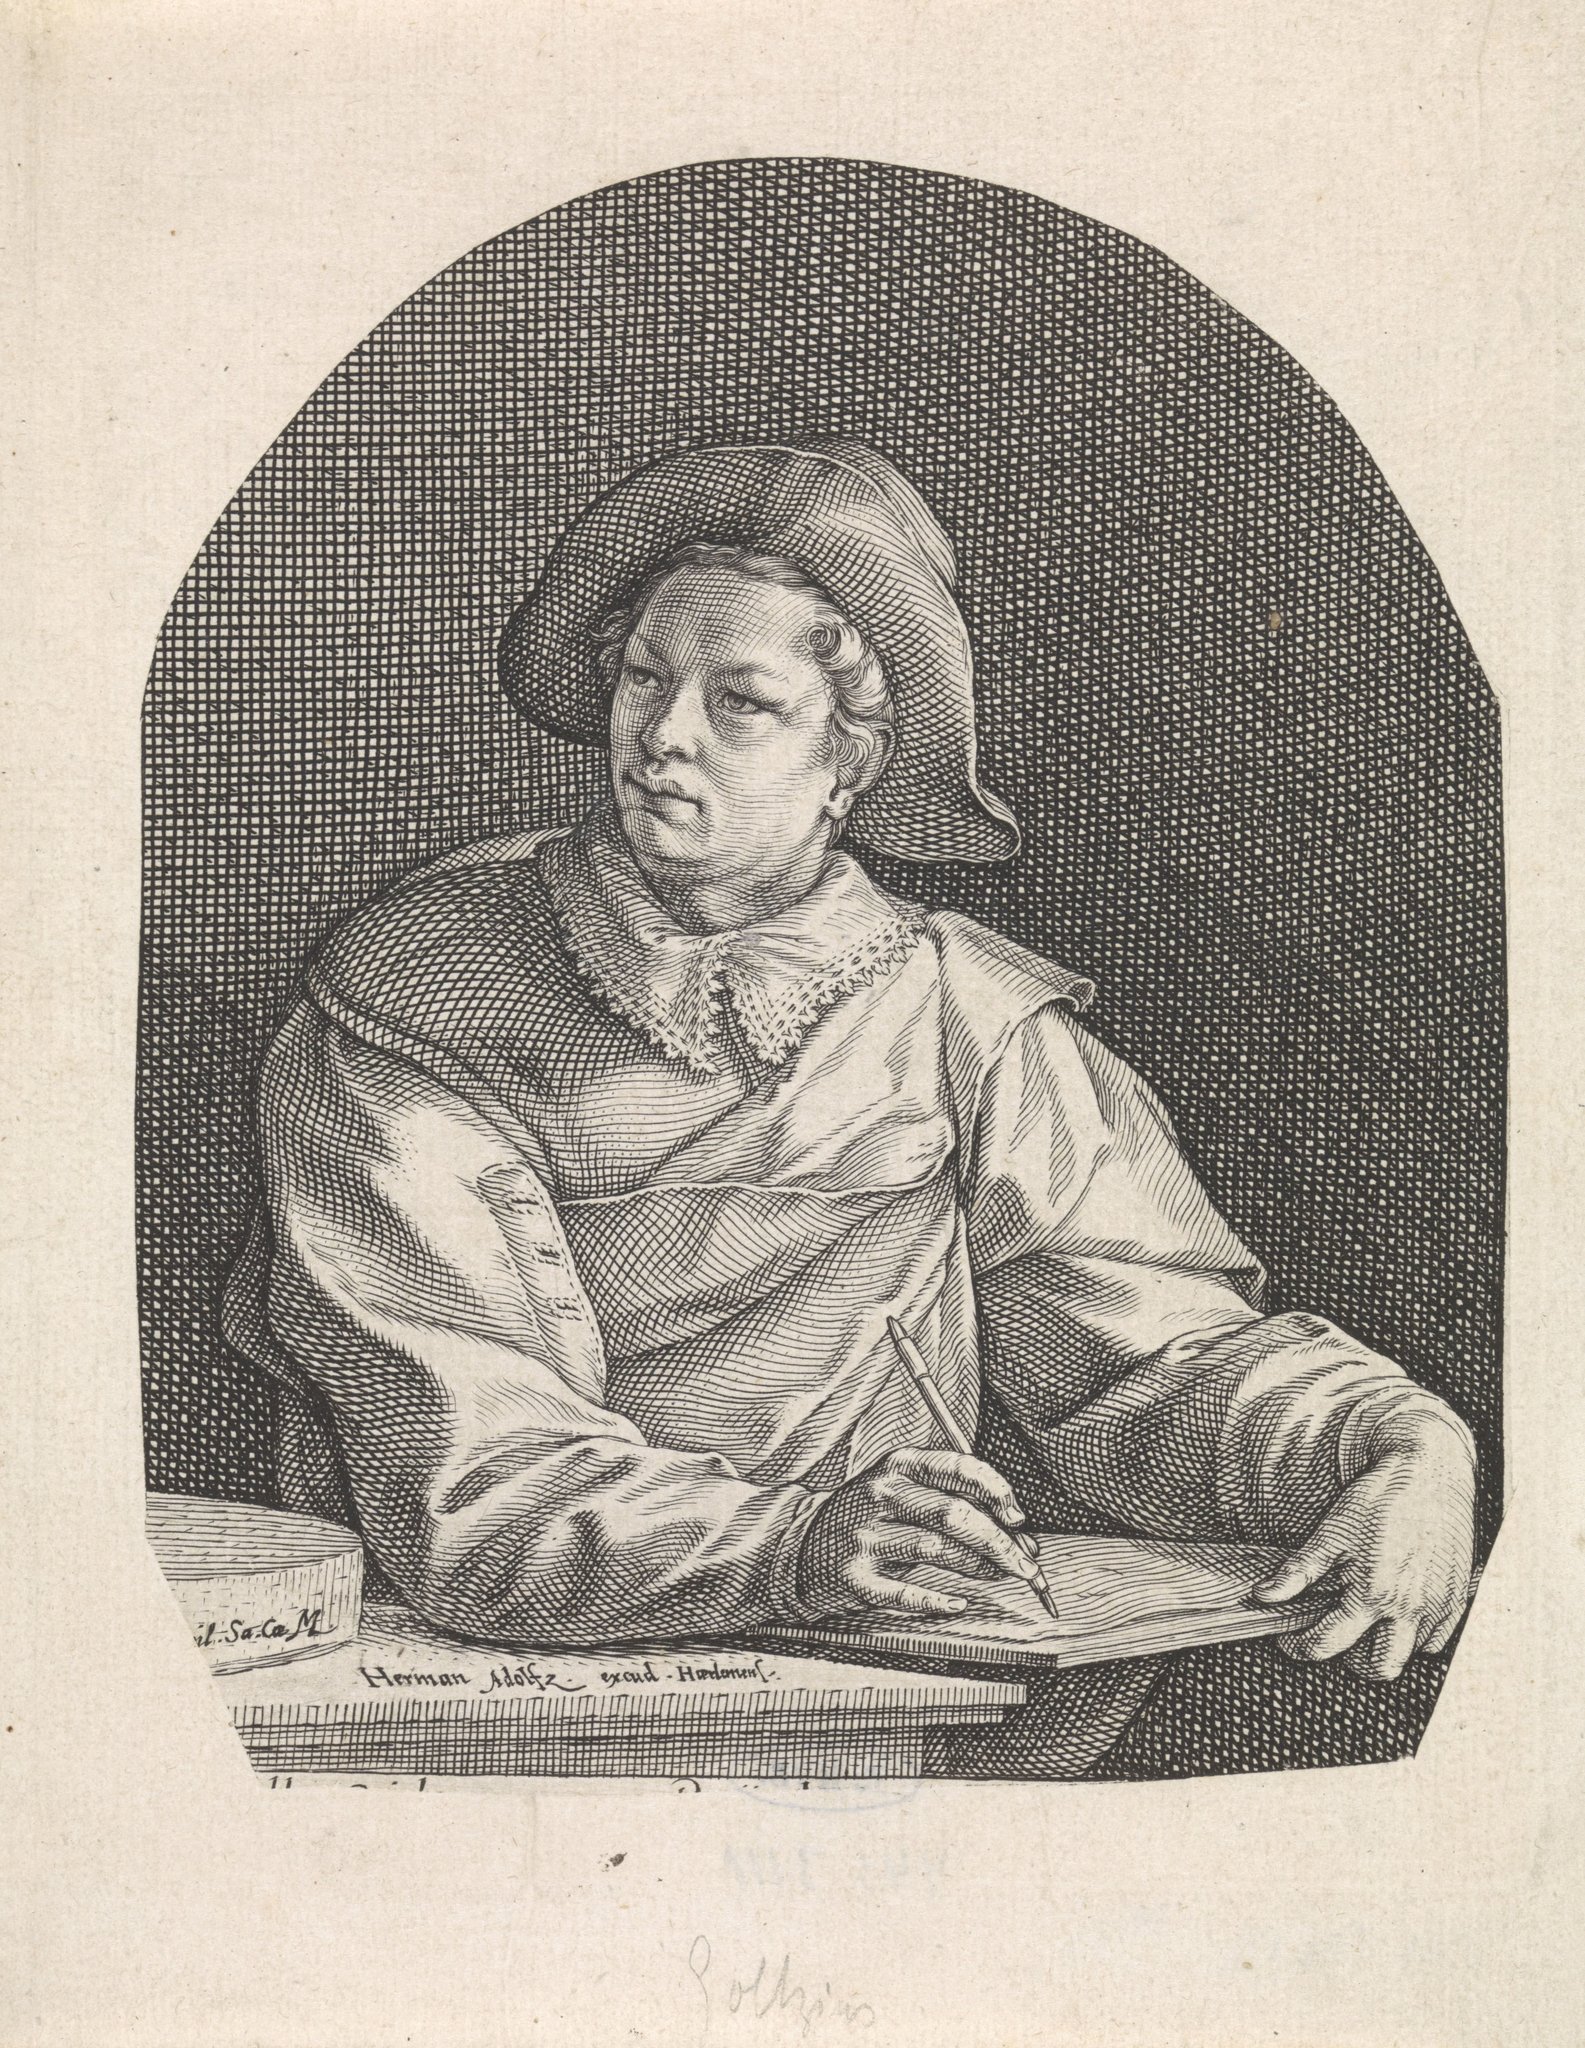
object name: print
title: Drie antieke beelden te Rome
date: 1592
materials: paper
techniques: engraving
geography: haarlem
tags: draughtsman studying classical remains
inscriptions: collector's mark: Lugt 2228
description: De tekenaar van de sculptuur Apollo Belvedere, kijkend naar links.